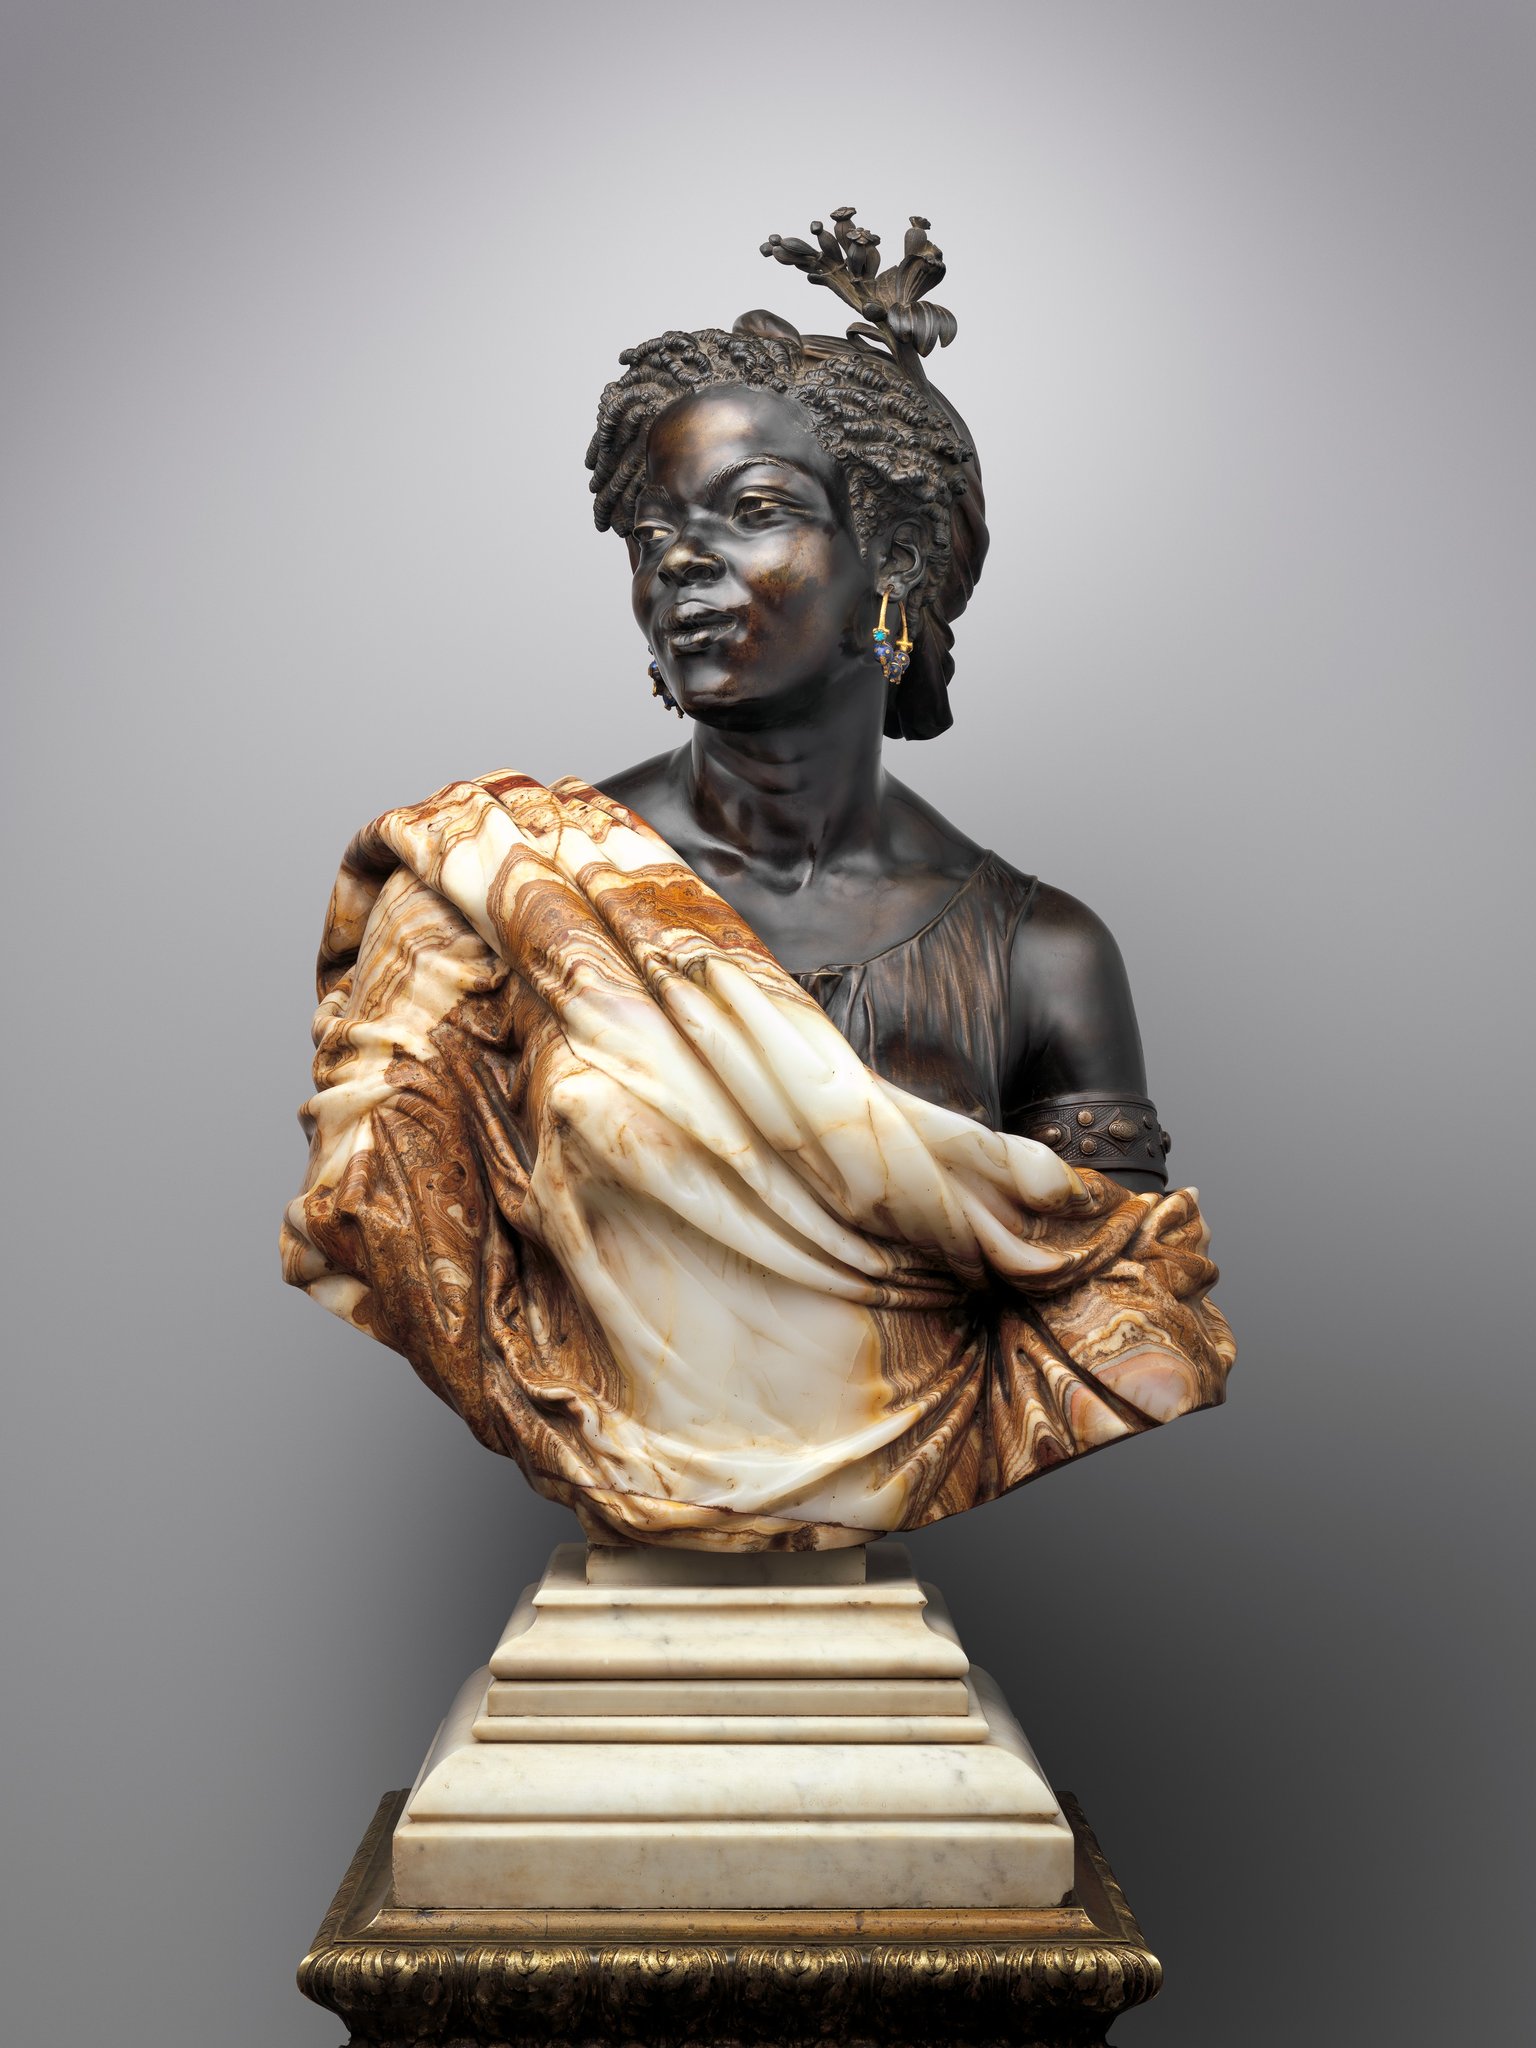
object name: bust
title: Woman from the French Colonies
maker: charles-henri-joseph cordier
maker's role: artist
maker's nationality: french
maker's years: 1827-1905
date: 1861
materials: bronze, enamel, marble, onyx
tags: women